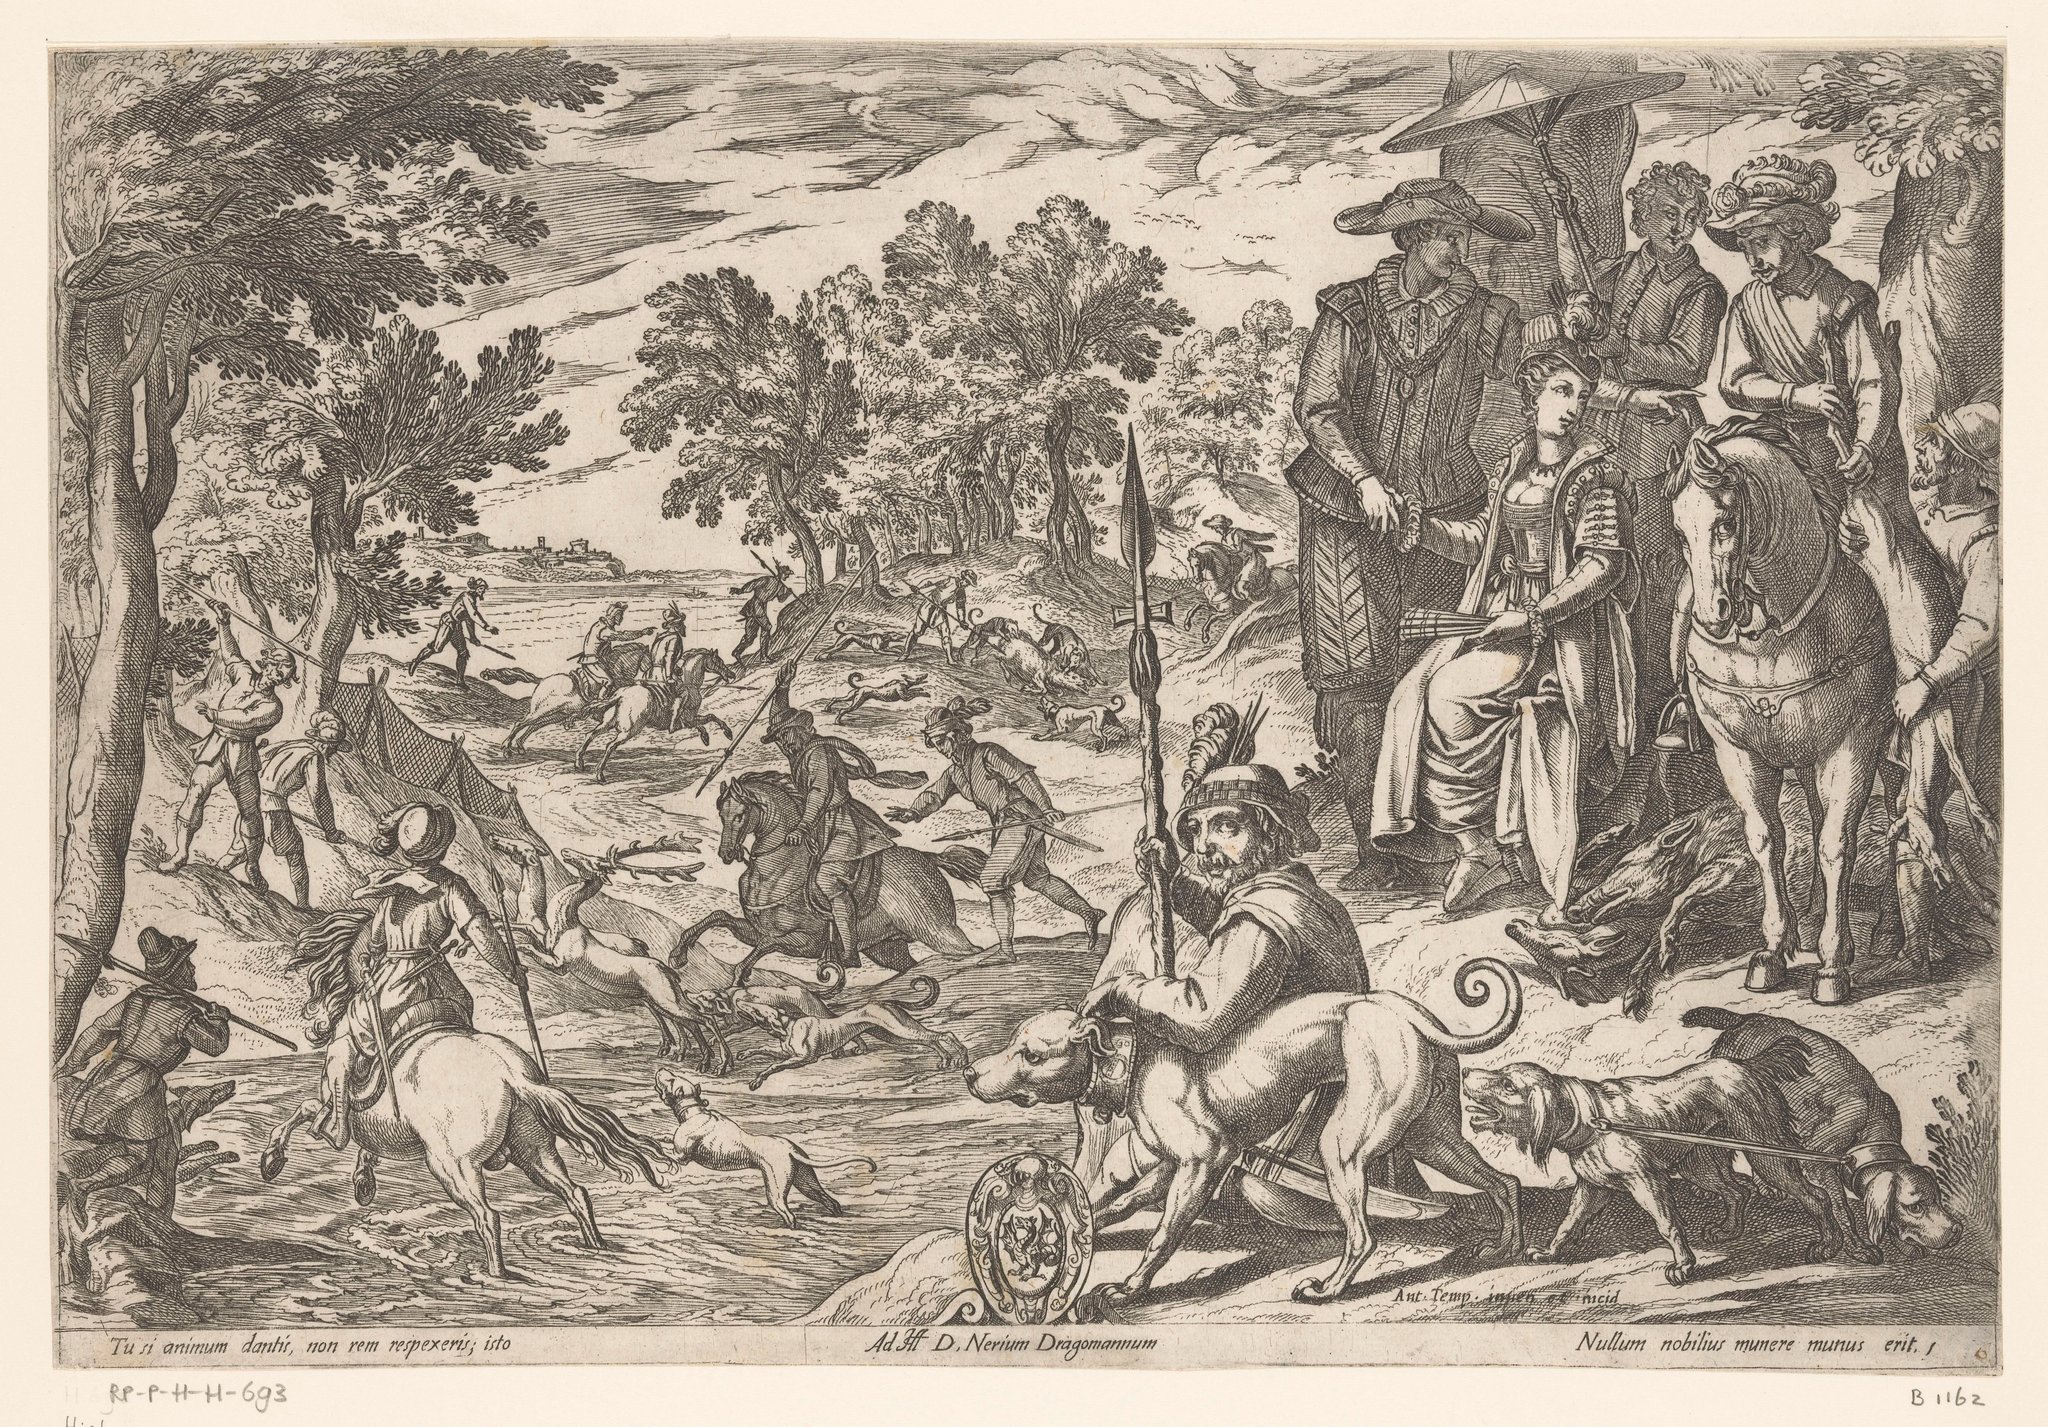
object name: print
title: Jachtscènes (deel 8)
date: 1565-1630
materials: paper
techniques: etching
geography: italy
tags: stag-hunting, hunter, hunters hunting (n.b.: in 1988-1990 this notation denoted the concept of 43c11421 'hunters resting during the hunt')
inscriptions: collector's mark: Lugt 11, number: ‘6’, collector's mark: ‘Hinloopen’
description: Landschap met jagers en jachthonden jagend op herten. Rechts een dame, omgeven door mannen, die toekijkt. Op de voorgrond een zittende jager met speer en drie honden. Midden onder het wapenschild van Nereo Dracomannio.